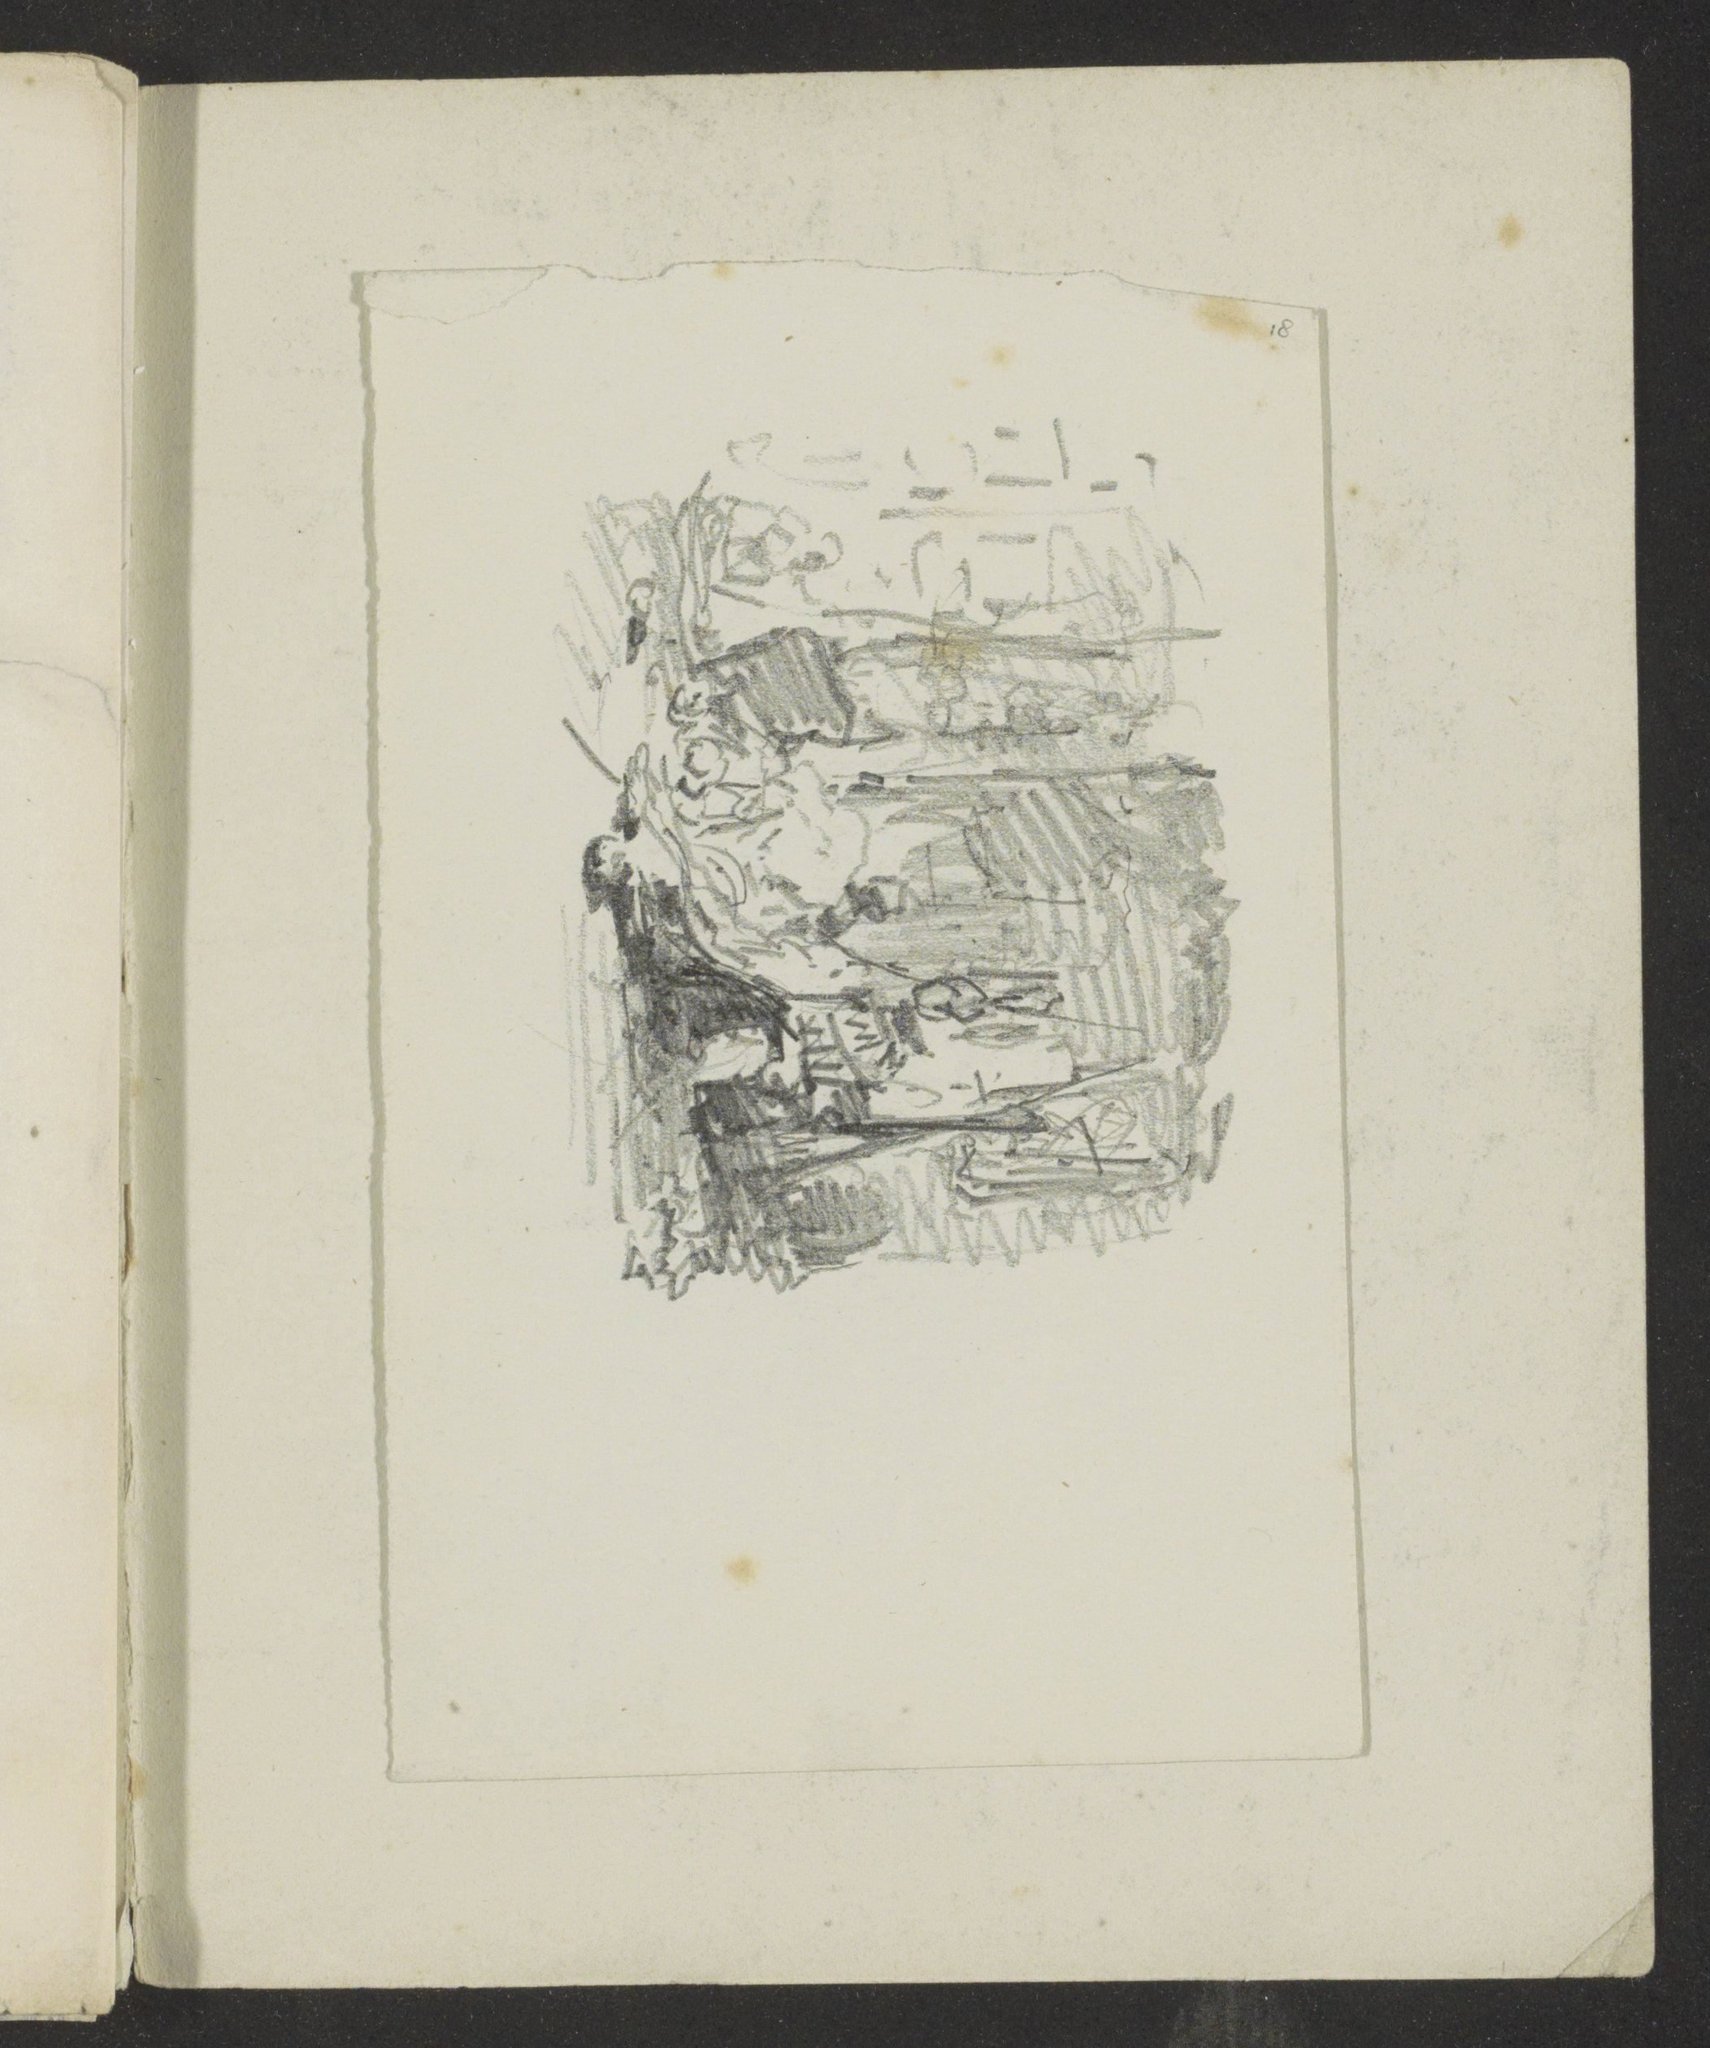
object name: sketchbook leaf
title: Studie, vermoedelijk een stilleven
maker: maria vos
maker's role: draughtsman, painter, print maker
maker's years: 1824-1906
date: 1834-1906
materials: paper, pencil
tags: still life of miscellaneous objects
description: Blad 18 recto, een los blad tussen pagina 17 en het achterste schutblad van een schetsboek met 17 bladen.